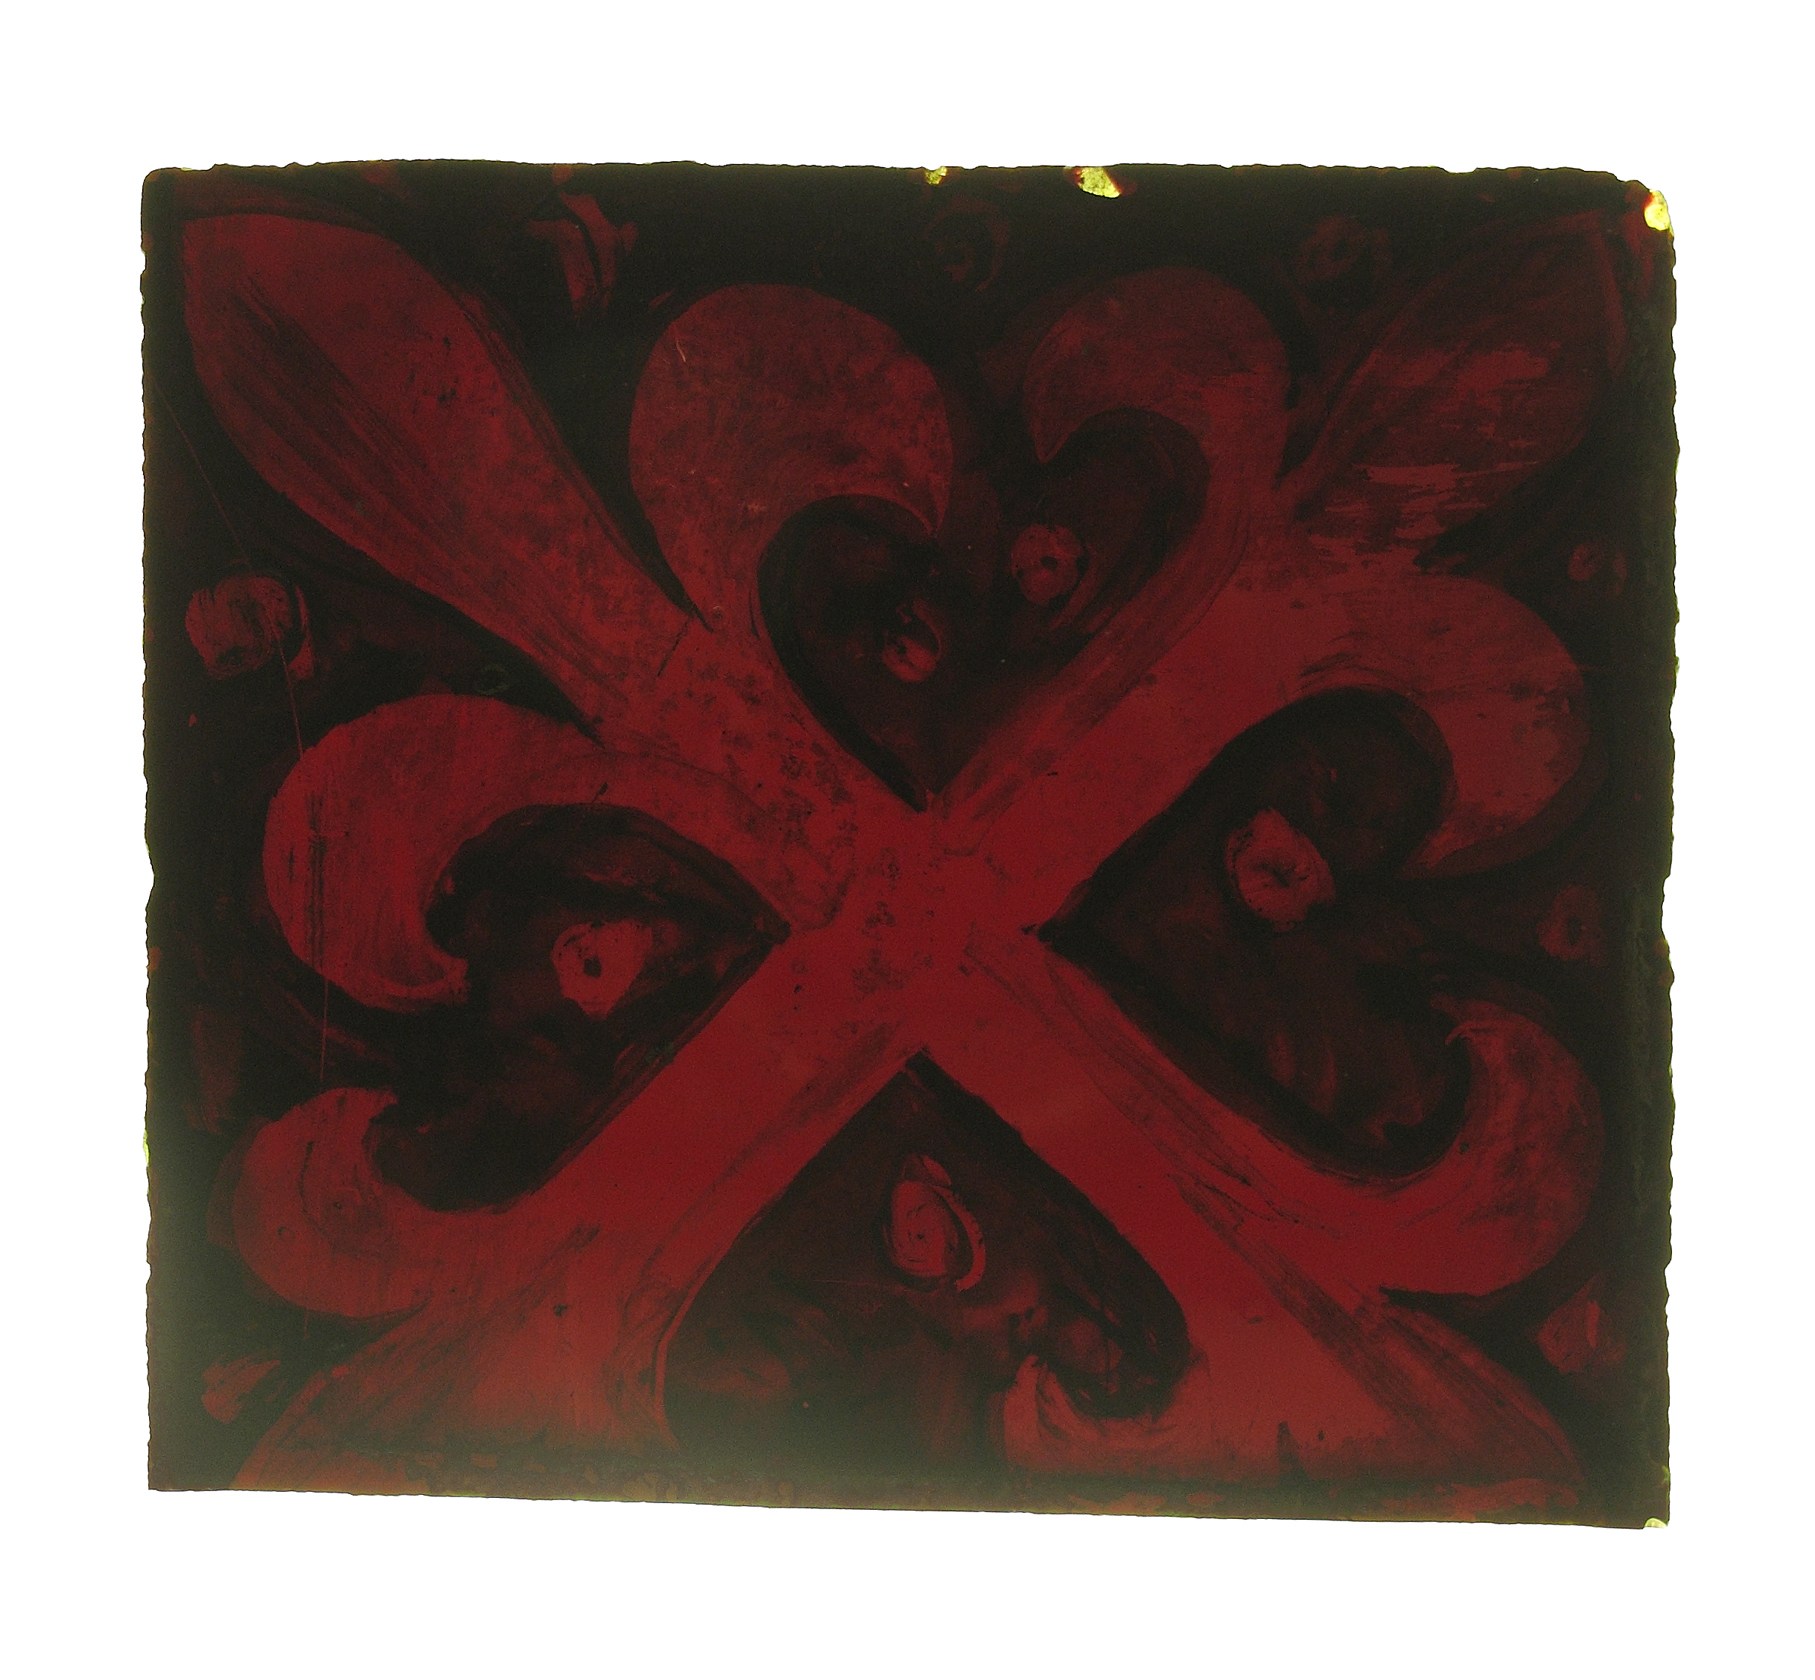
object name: fragment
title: Glass Fragment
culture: european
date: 1101-1700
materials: glass, metal, paint